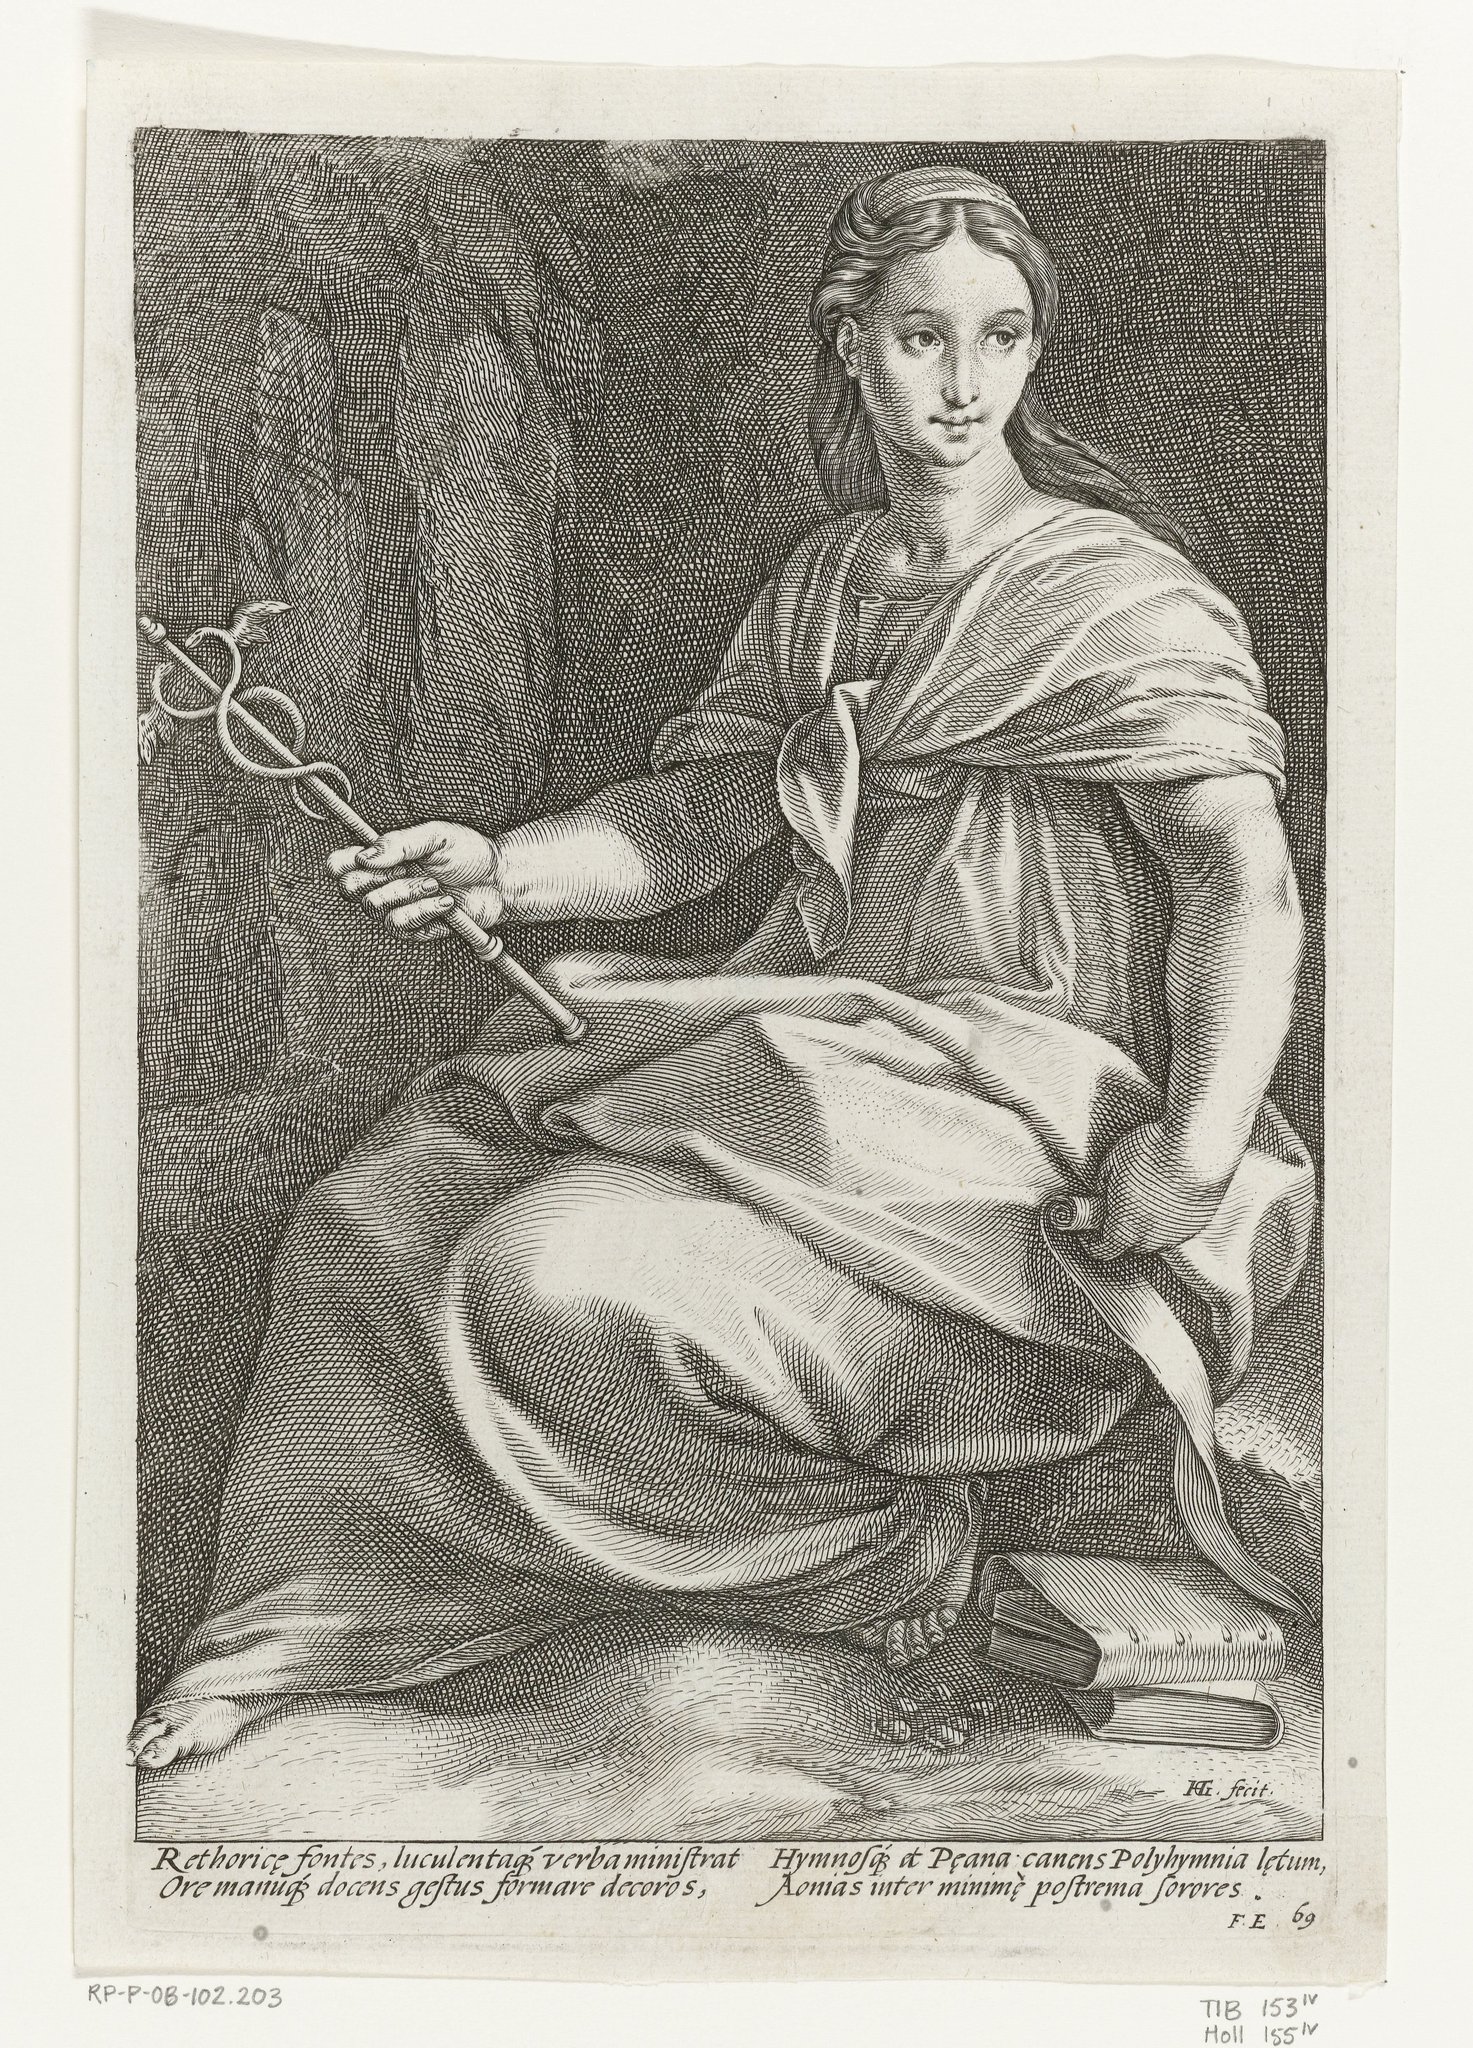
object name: print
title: Polyhymnia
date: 1592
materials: paper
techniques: engraving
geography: haarlem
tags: polyhymnia (one of the muses); 'polinnia' (ripa)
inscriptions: collector's mark: Lugt 2228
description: De muse Polyhymnia zittend met caduseus. Met Latijnse tekst van Franco Estius in de marge onder de prent.